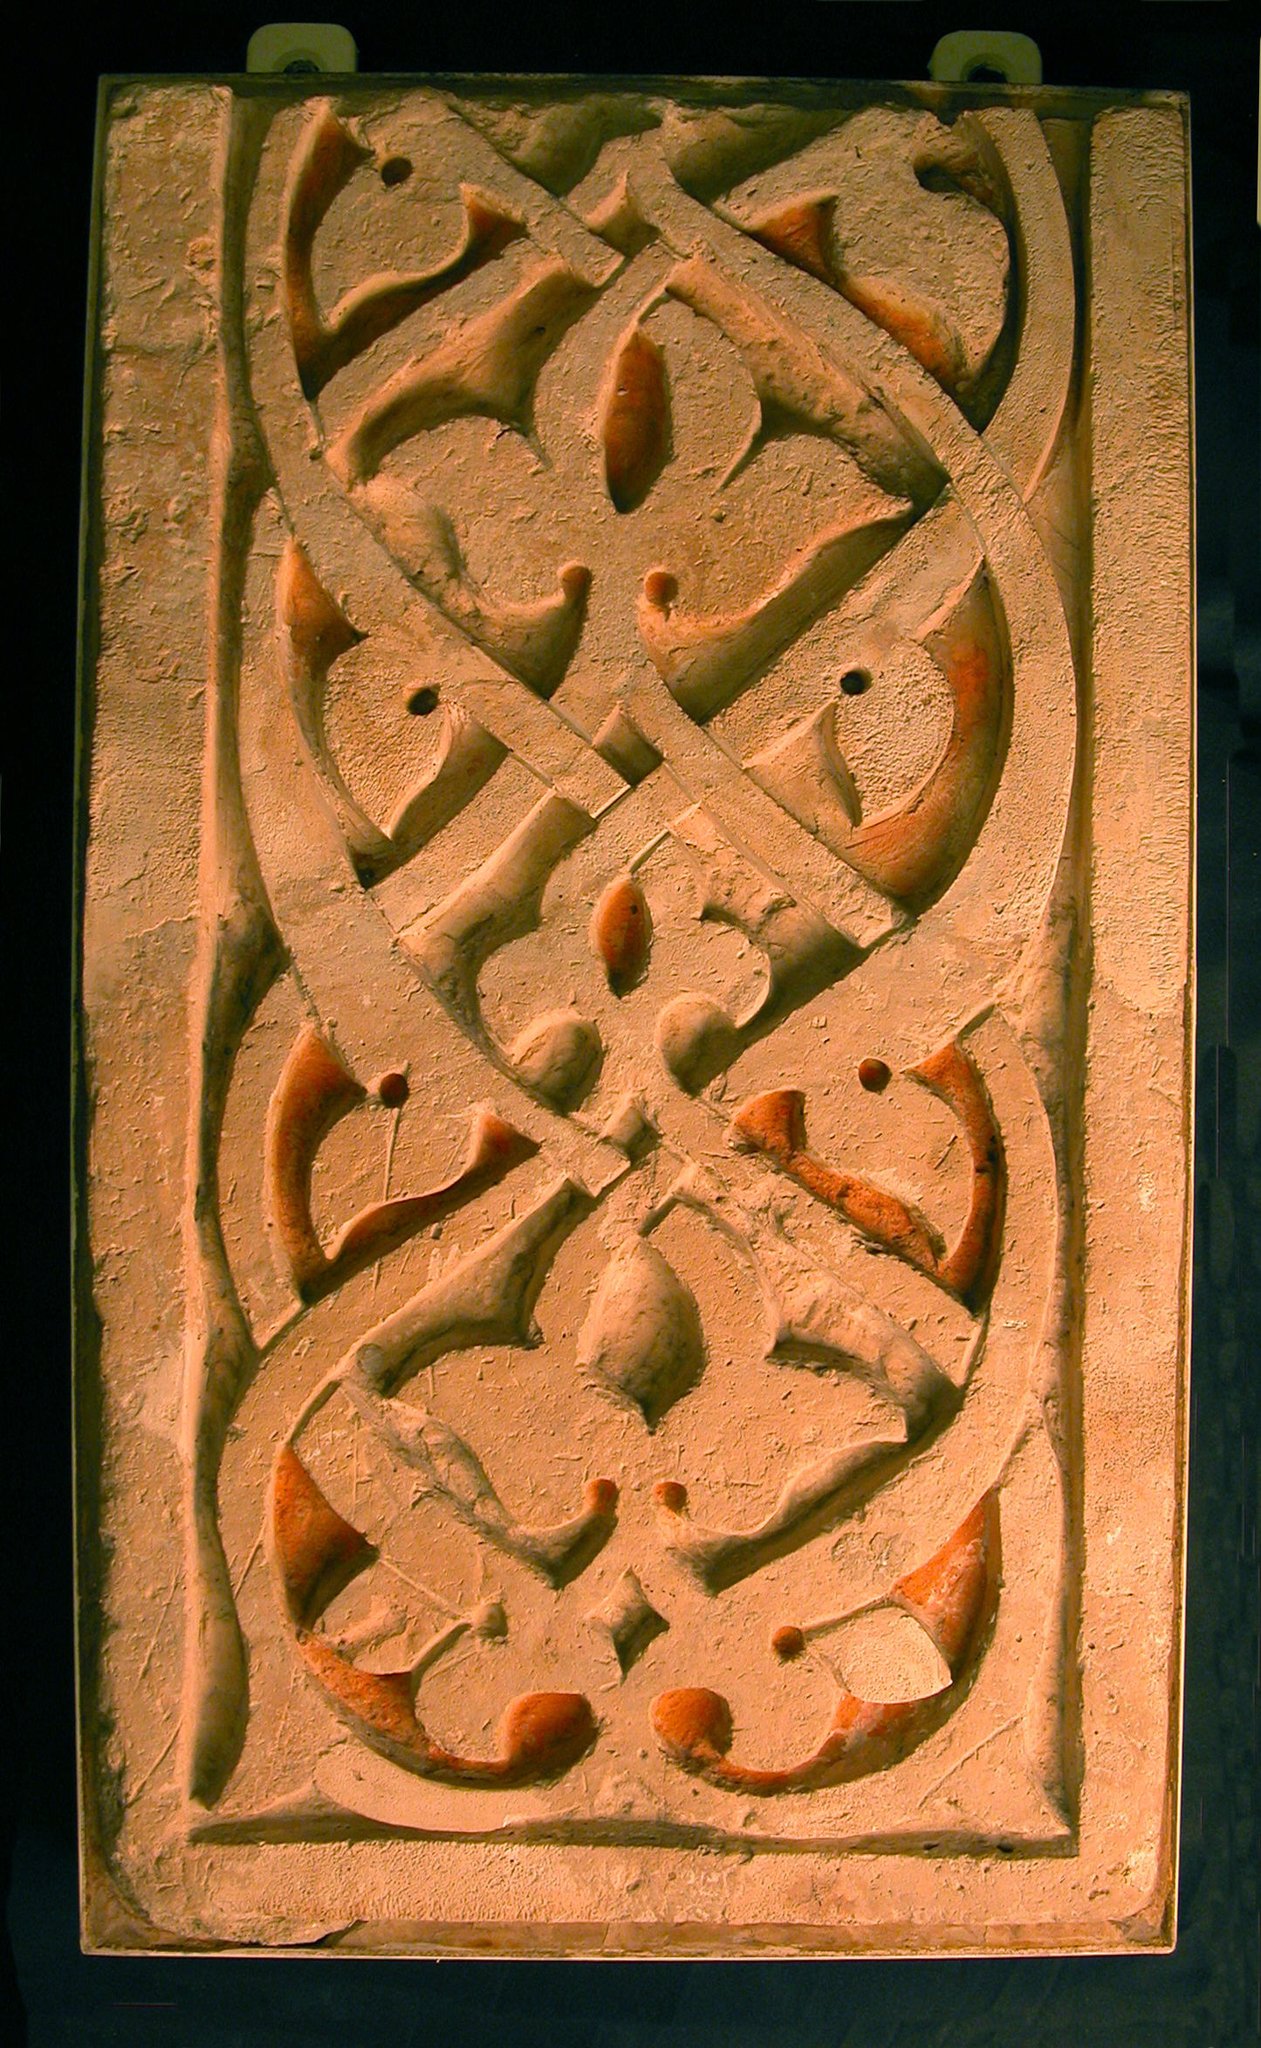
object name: frieze fragment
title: Fragment of a Frieze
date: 1001-1100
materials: terracotta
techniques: carving, painting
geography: iran